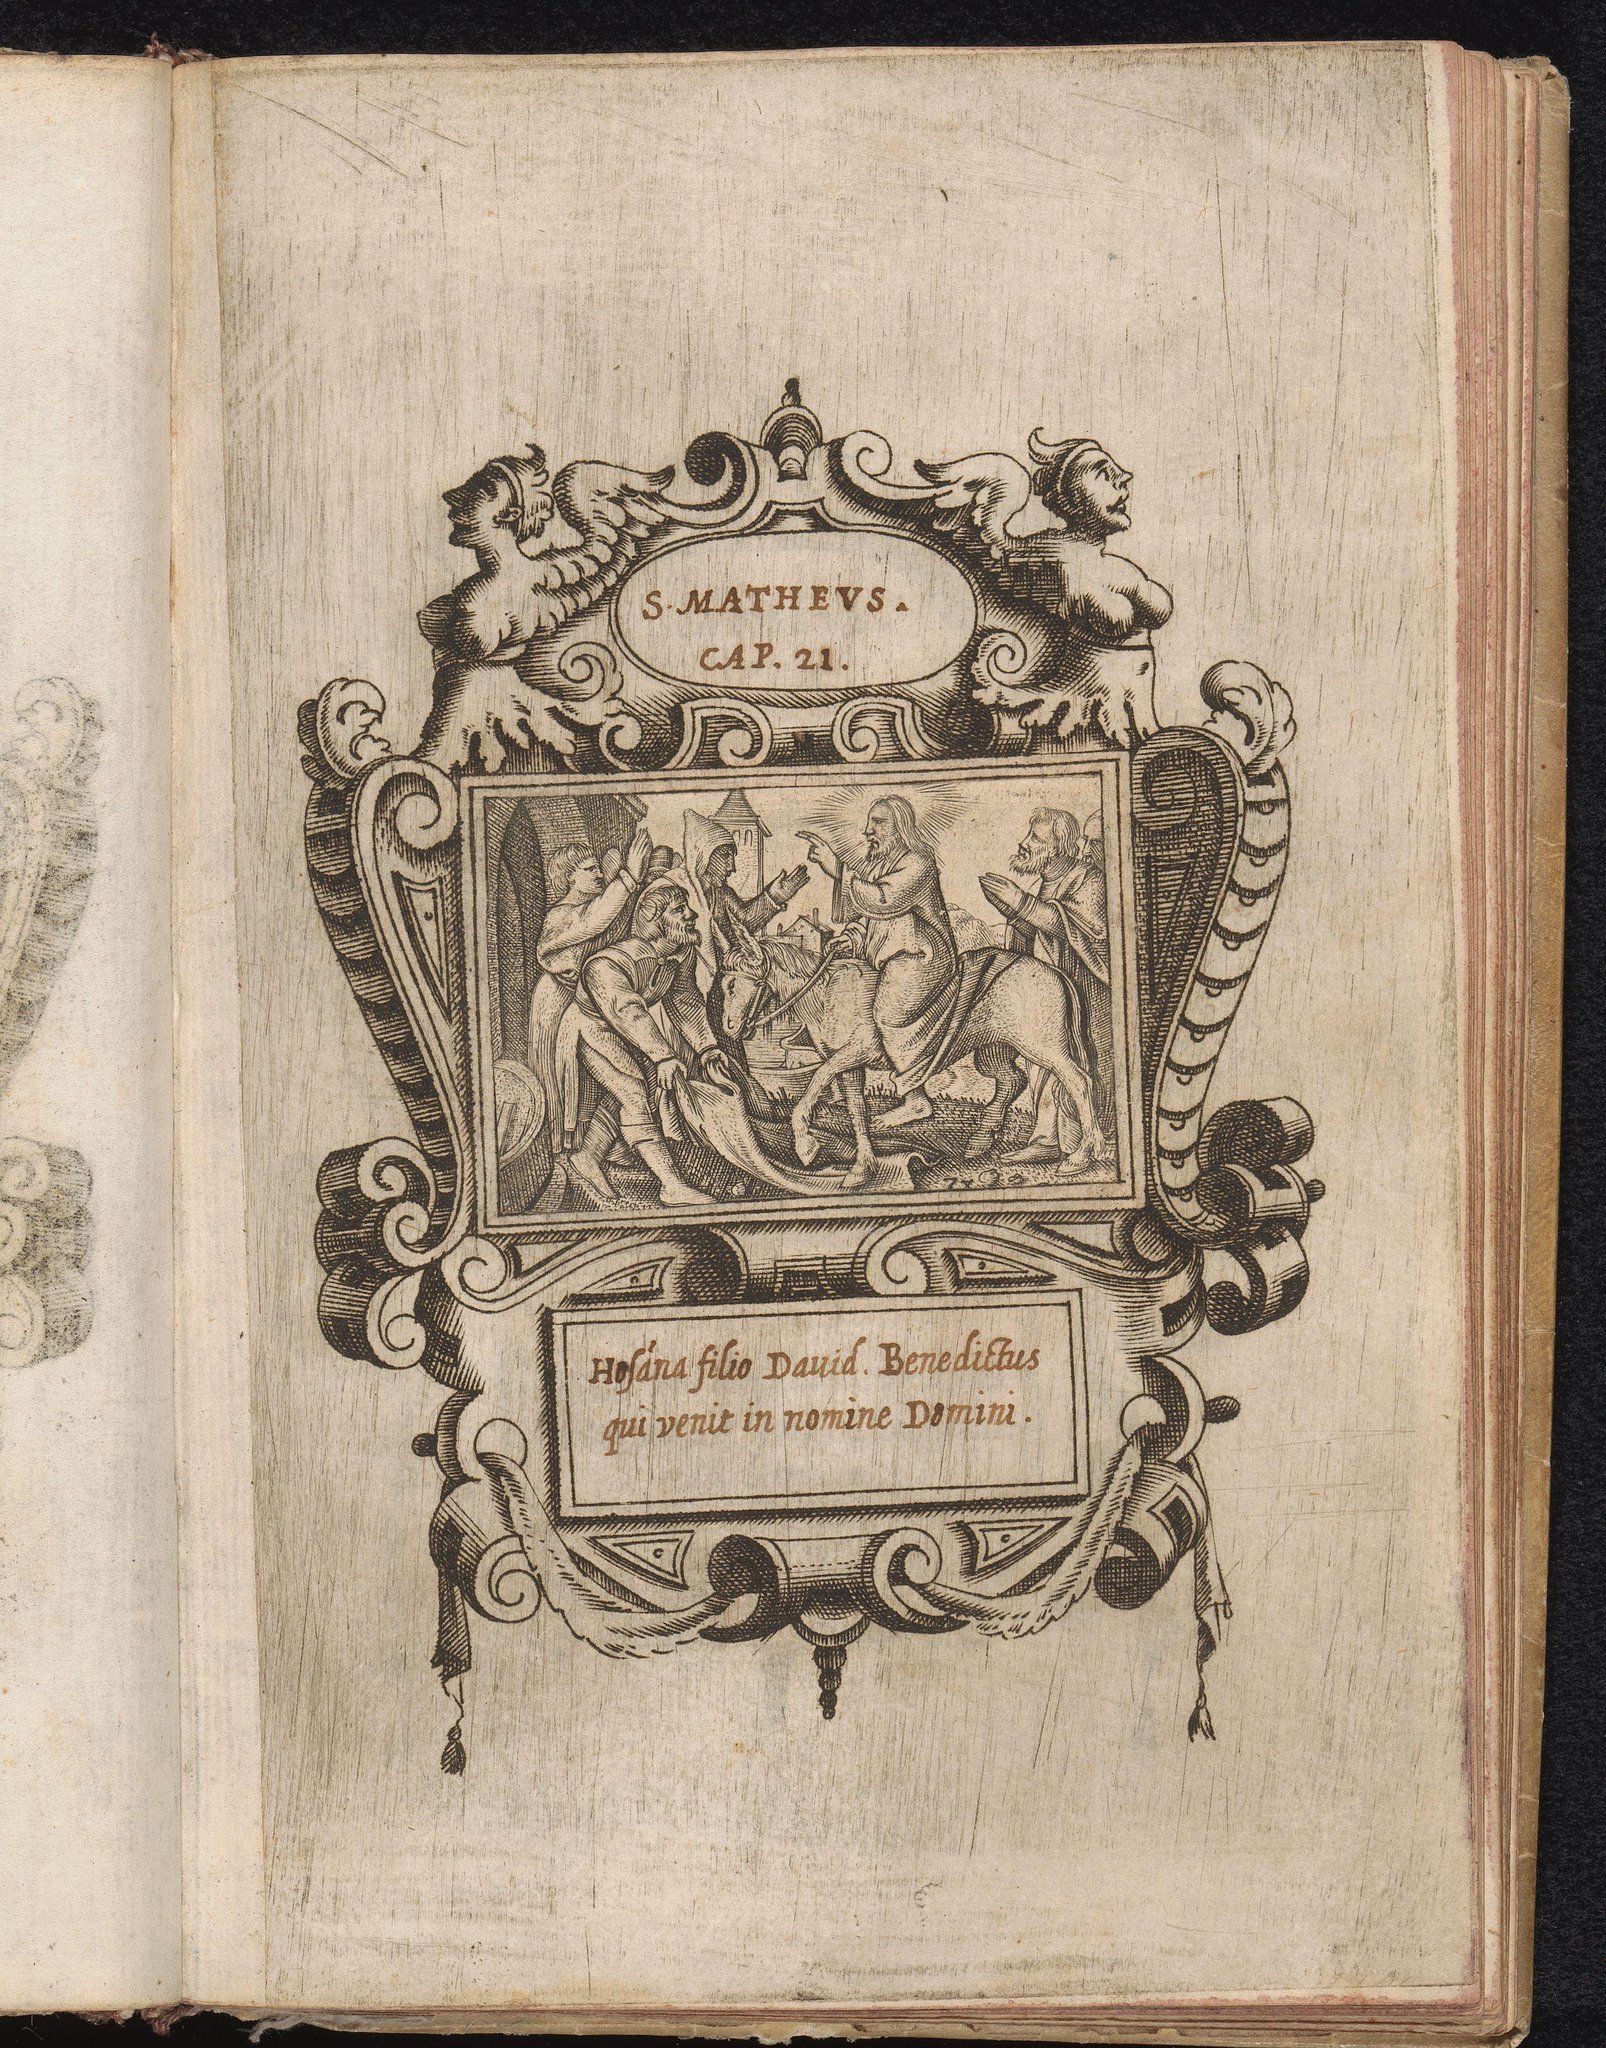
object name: print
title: Intocht van Christus in Jeruzalem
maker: Anonymous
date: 1570-1610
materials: paper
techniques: engraving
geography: antwerp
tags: entry into jerusalem: people spreading their clothes before christ on the ass, and waving palm branches (matthew 21:1-11, 21:14-16; mark 11:1-11; luke 19:28-40; john 12:12-19)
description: Intocht van Christus in Jeruzalem. Onderdeel van een prentalbum met titelprent en 56 scènes uit het Nieuwe Testament. Elke voorstelling gemonteerd in een gravure met ornamentele cartouches waarin een venster is gesneden en voorzien van handgeschreven bijbelpassages.